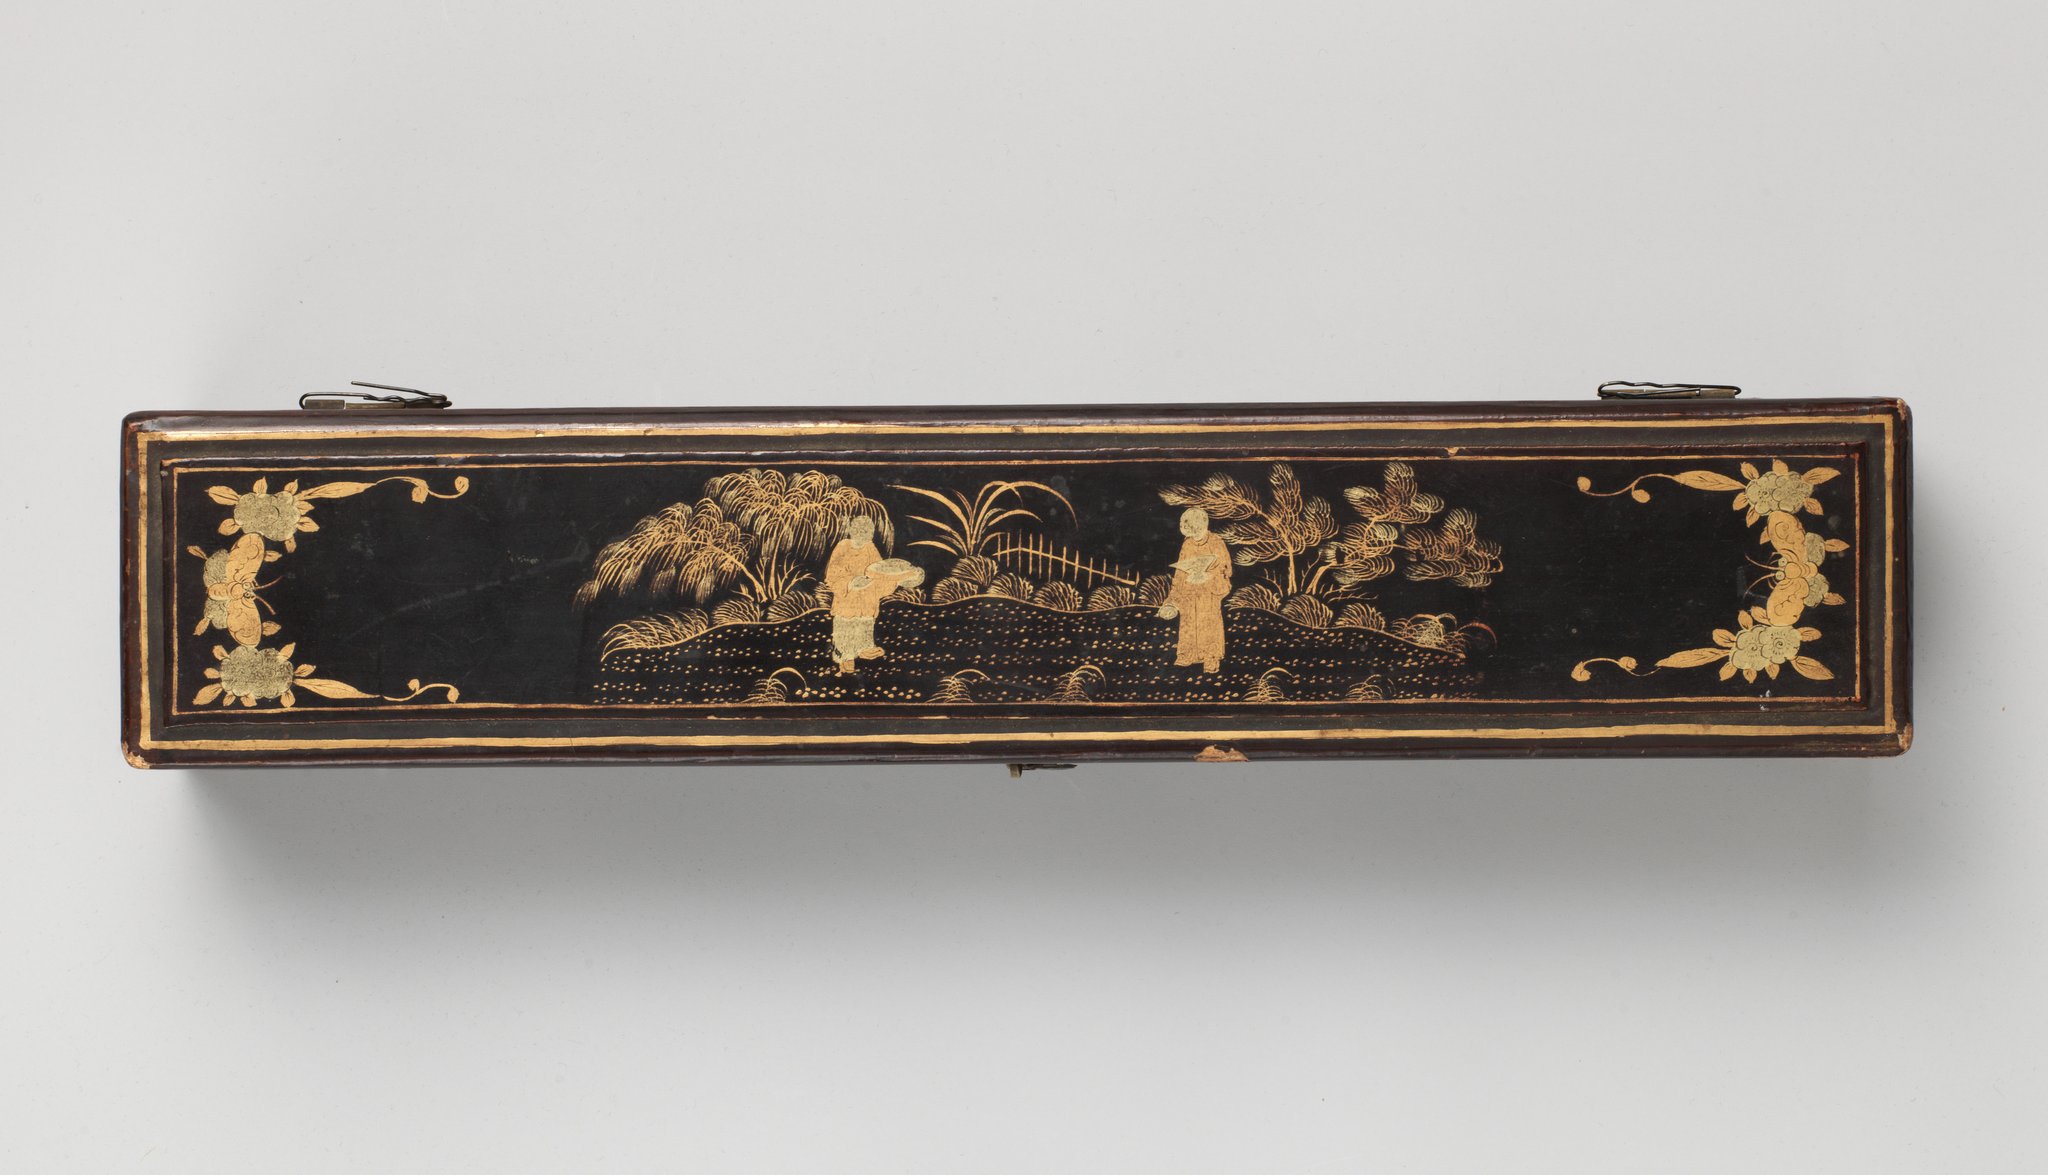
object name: fan box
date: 1801-1900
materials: paper, silk, wood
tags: men,butterflies,roses,trees